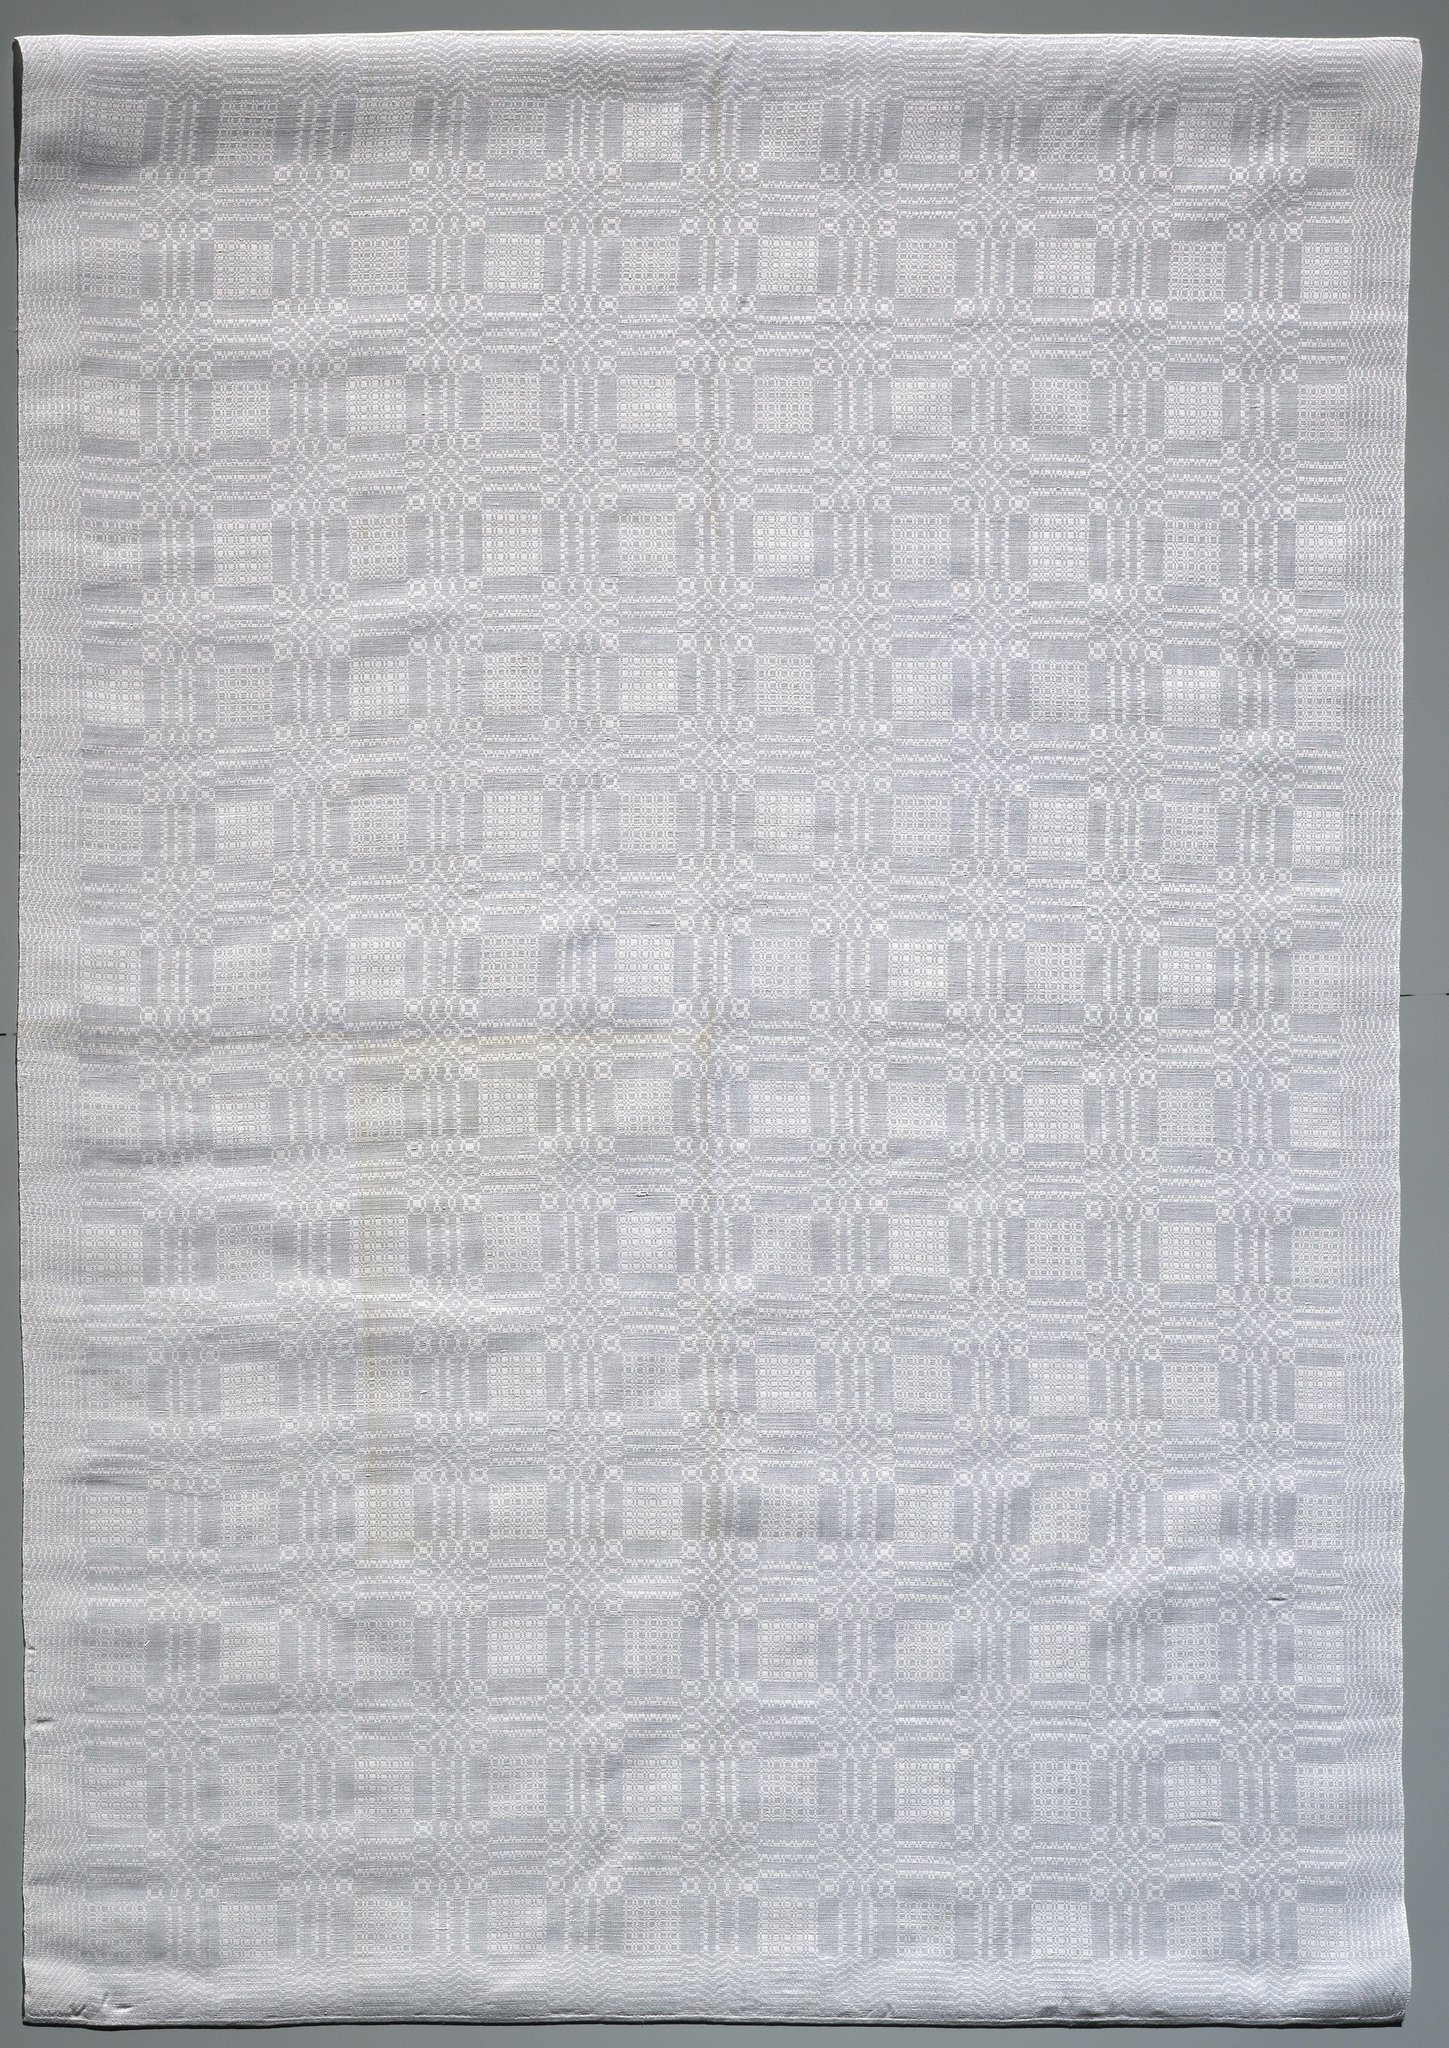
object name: napkin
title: Servet van linnen met pellenpatroon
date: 1700-1800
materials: linen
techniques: peeled fabric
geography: netherlands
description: Linnen servet met pellen patroon. Merk SP 24.